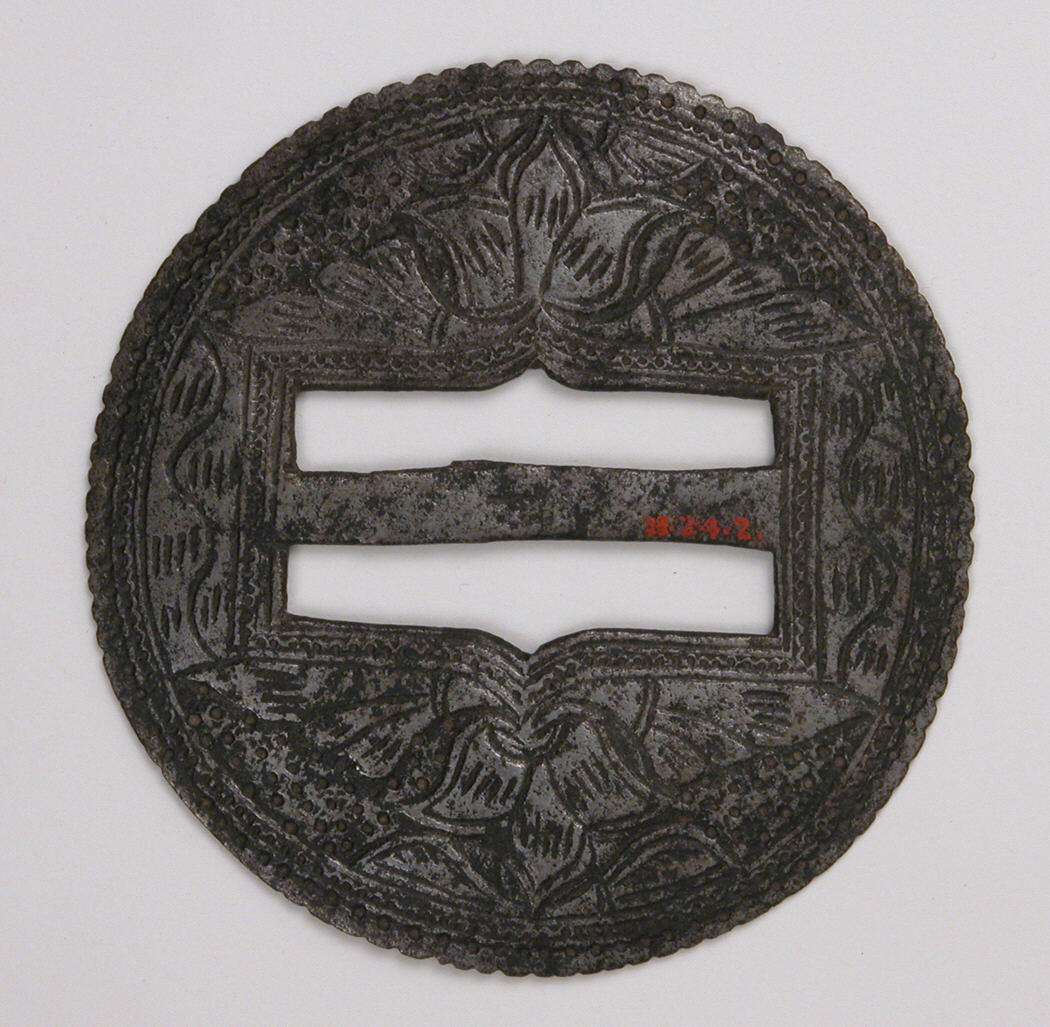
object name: buckle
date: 1601-1700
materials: steel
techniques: gilding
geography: india